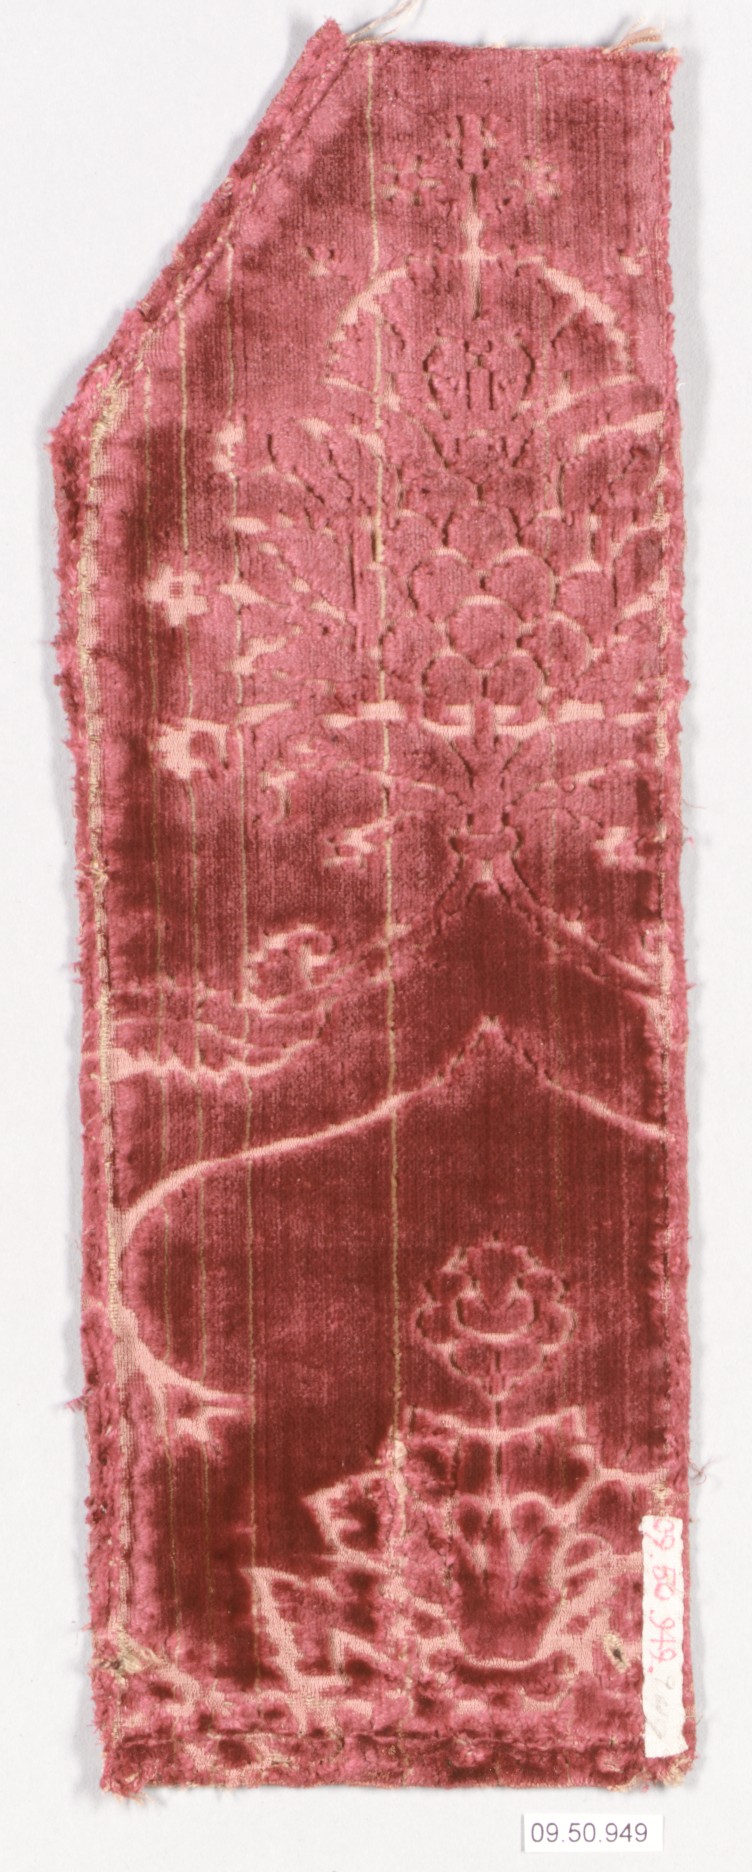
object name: piece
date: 1501-1600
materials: silk